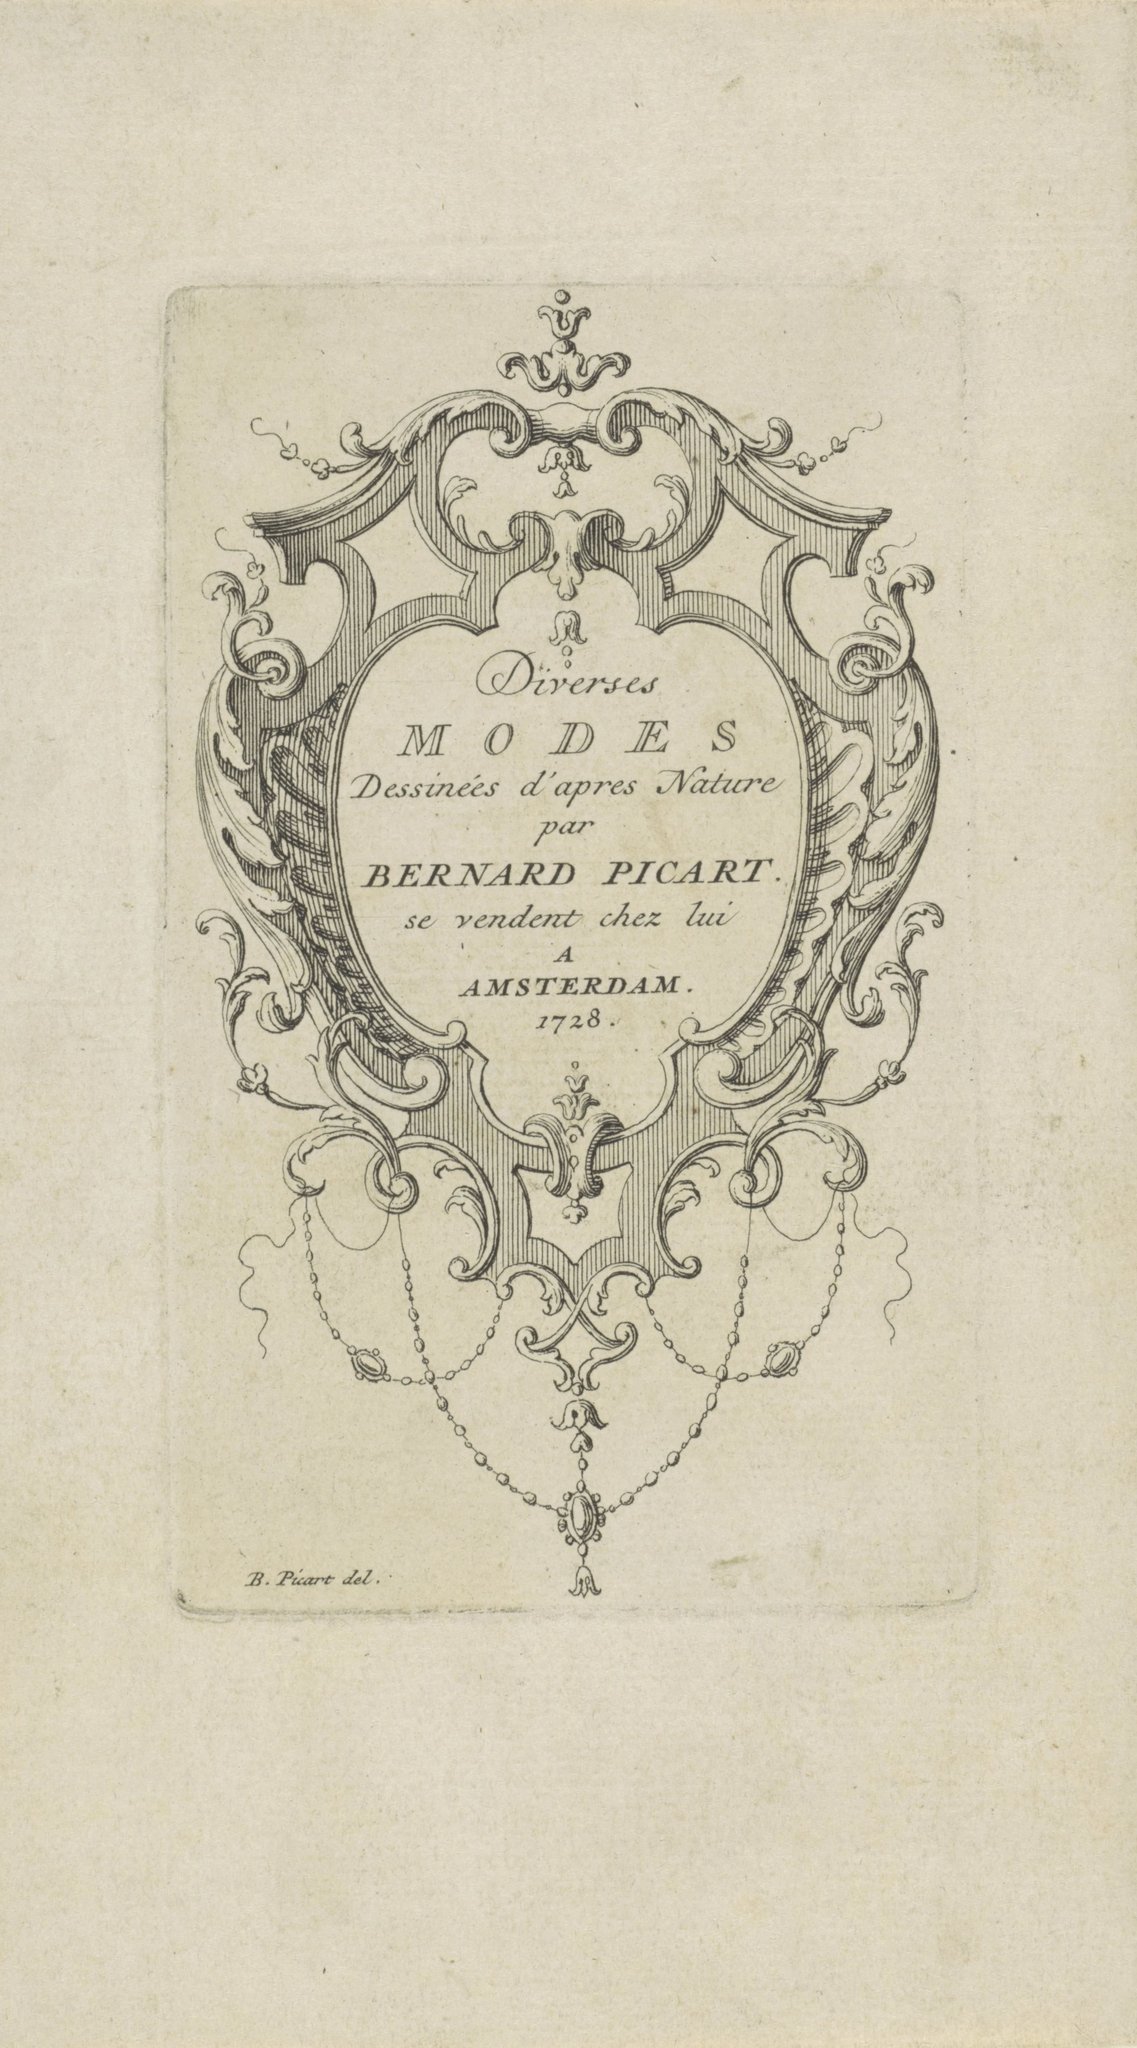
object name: print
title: Diverses modes Dessinées d'apres Nature (...)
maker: bernard picart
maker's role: draughtsman, print maker, publisher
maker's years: 1673-1733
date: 1728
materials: paper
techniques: engraving, etching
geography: amsterdam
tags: ornaments ~ art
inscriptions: collector's mark: Lugt 2228